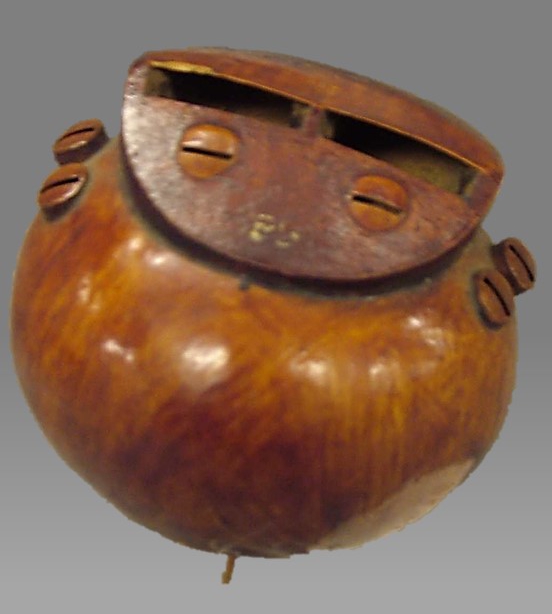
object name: ko tze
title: Ko-Tze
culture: chinese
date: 1867-1900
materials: bamboo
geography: china